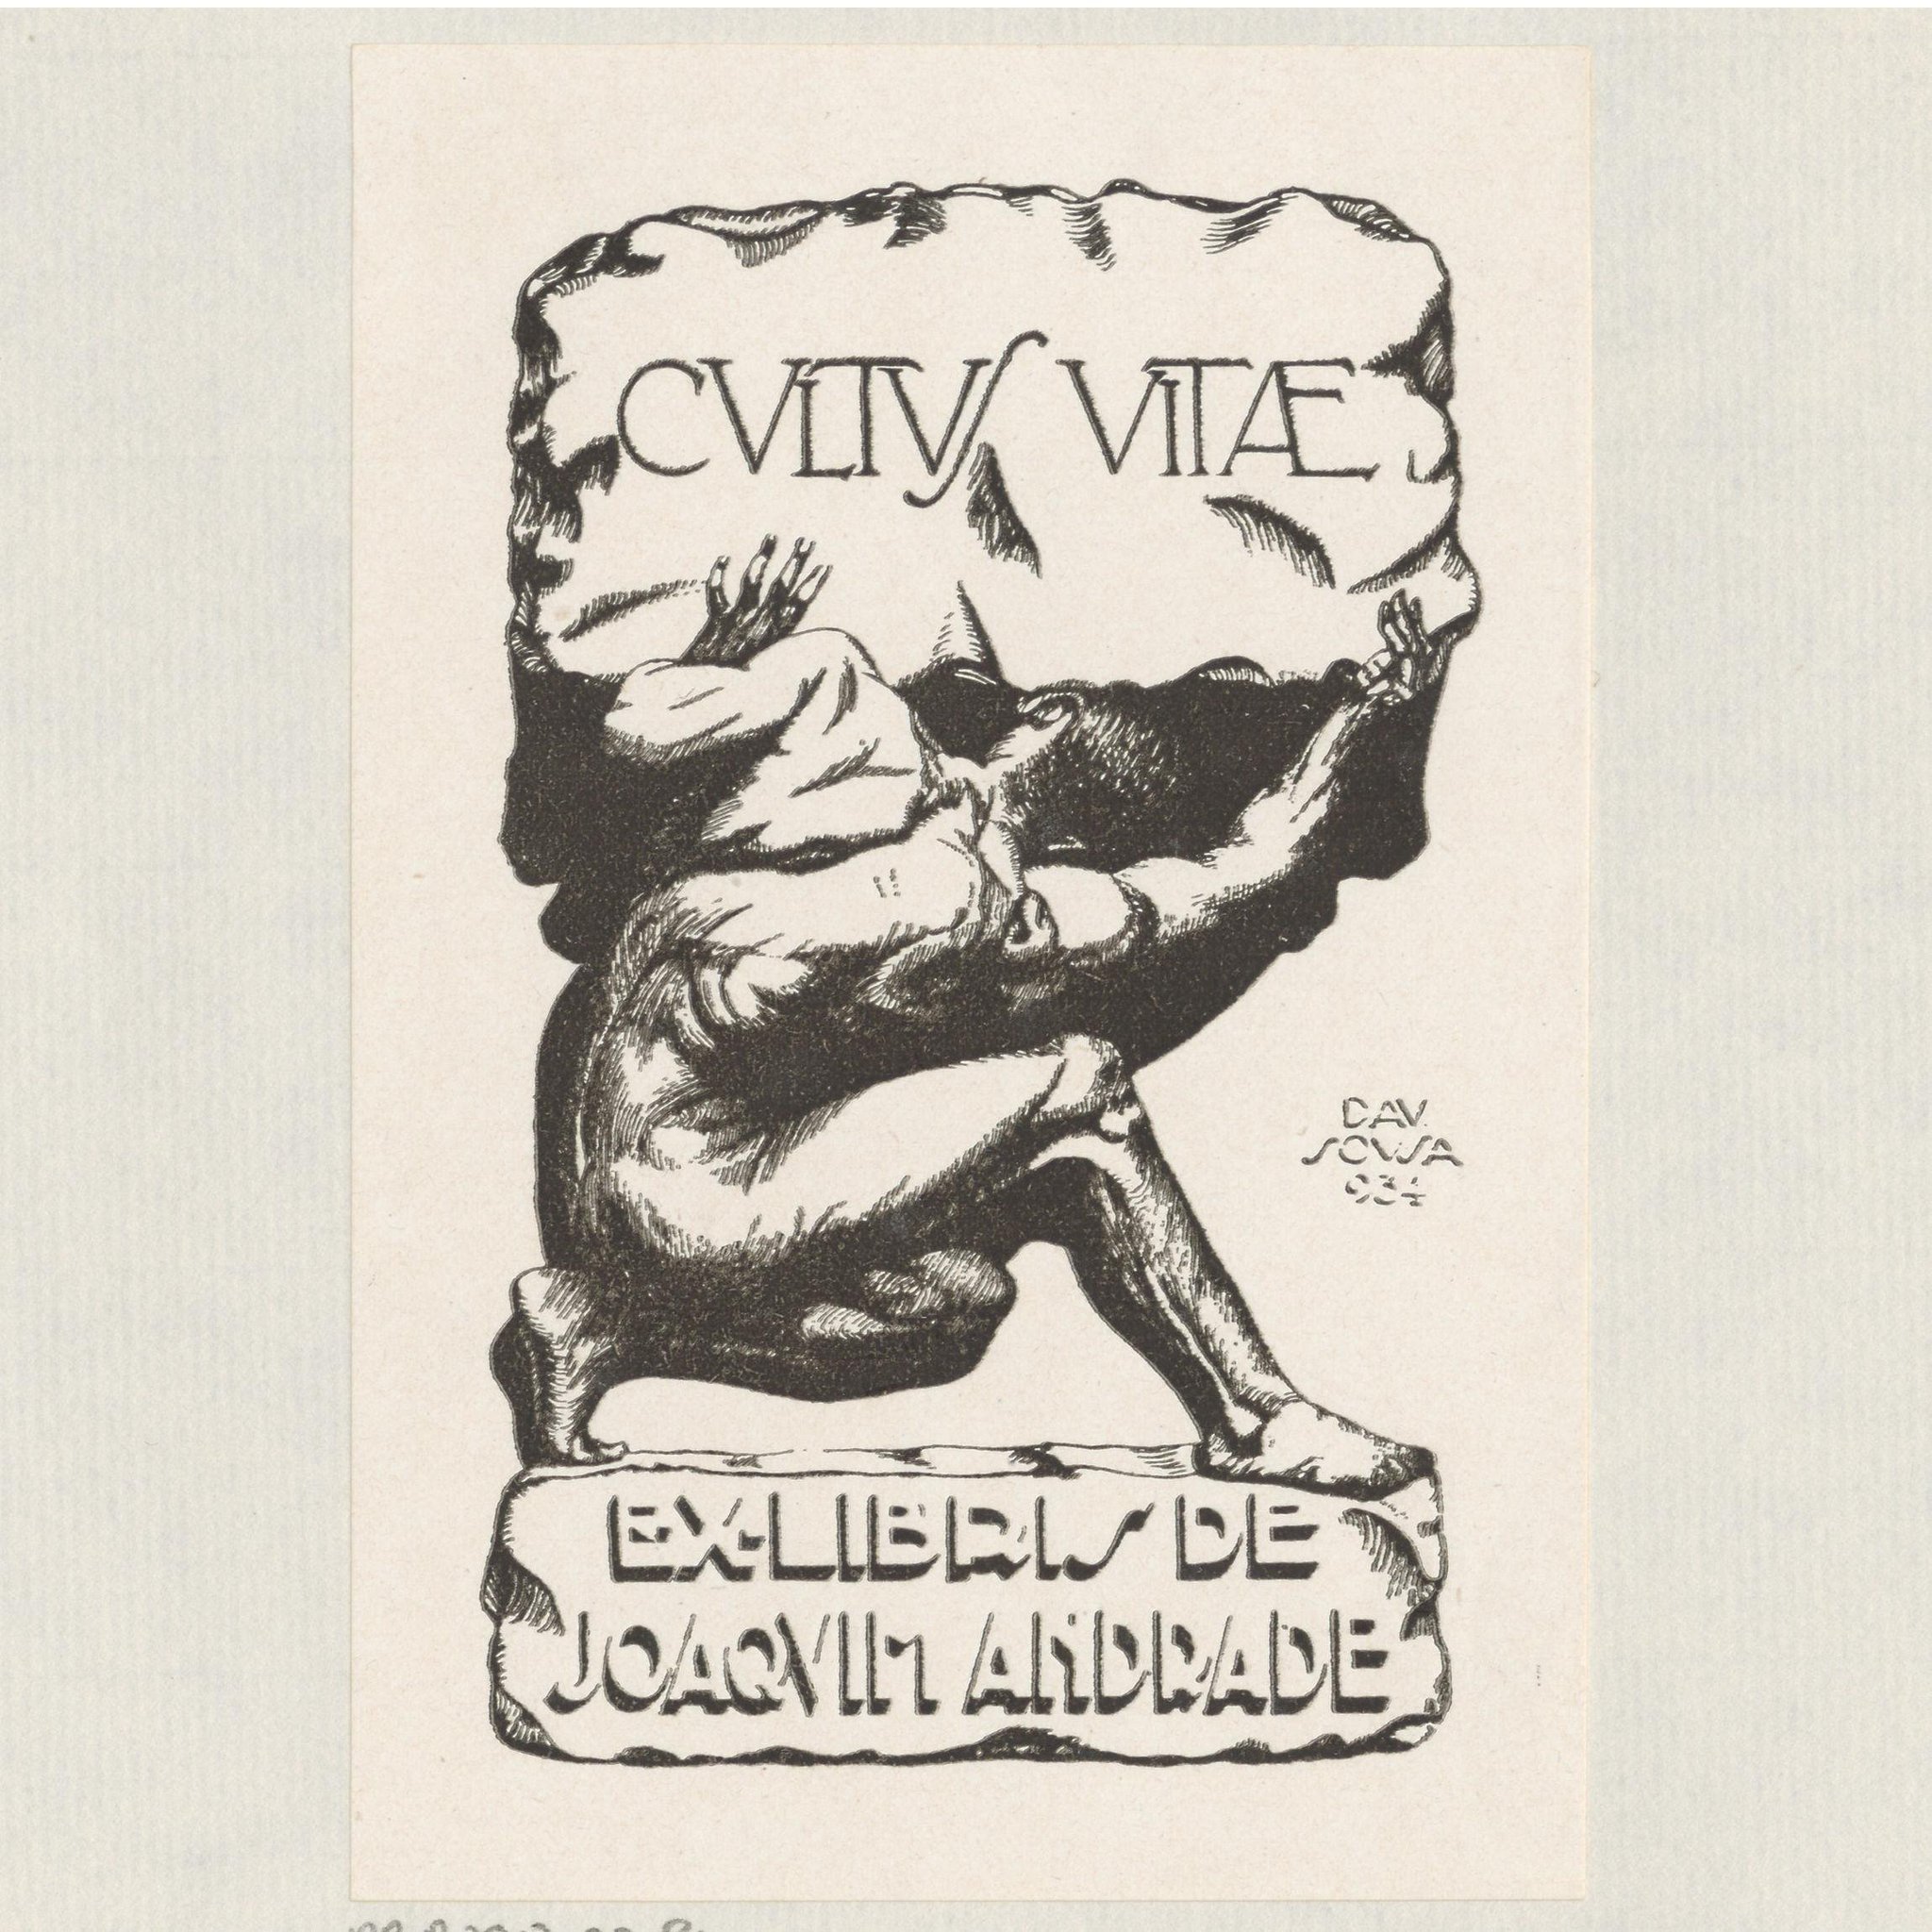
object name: bookplate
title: Ex libris van Joaquim Andrade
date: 1934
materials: paper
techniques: printing block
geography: portugal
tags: carrying a person on one's back, man (showing himself) undressed, quasi-nude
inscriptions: date